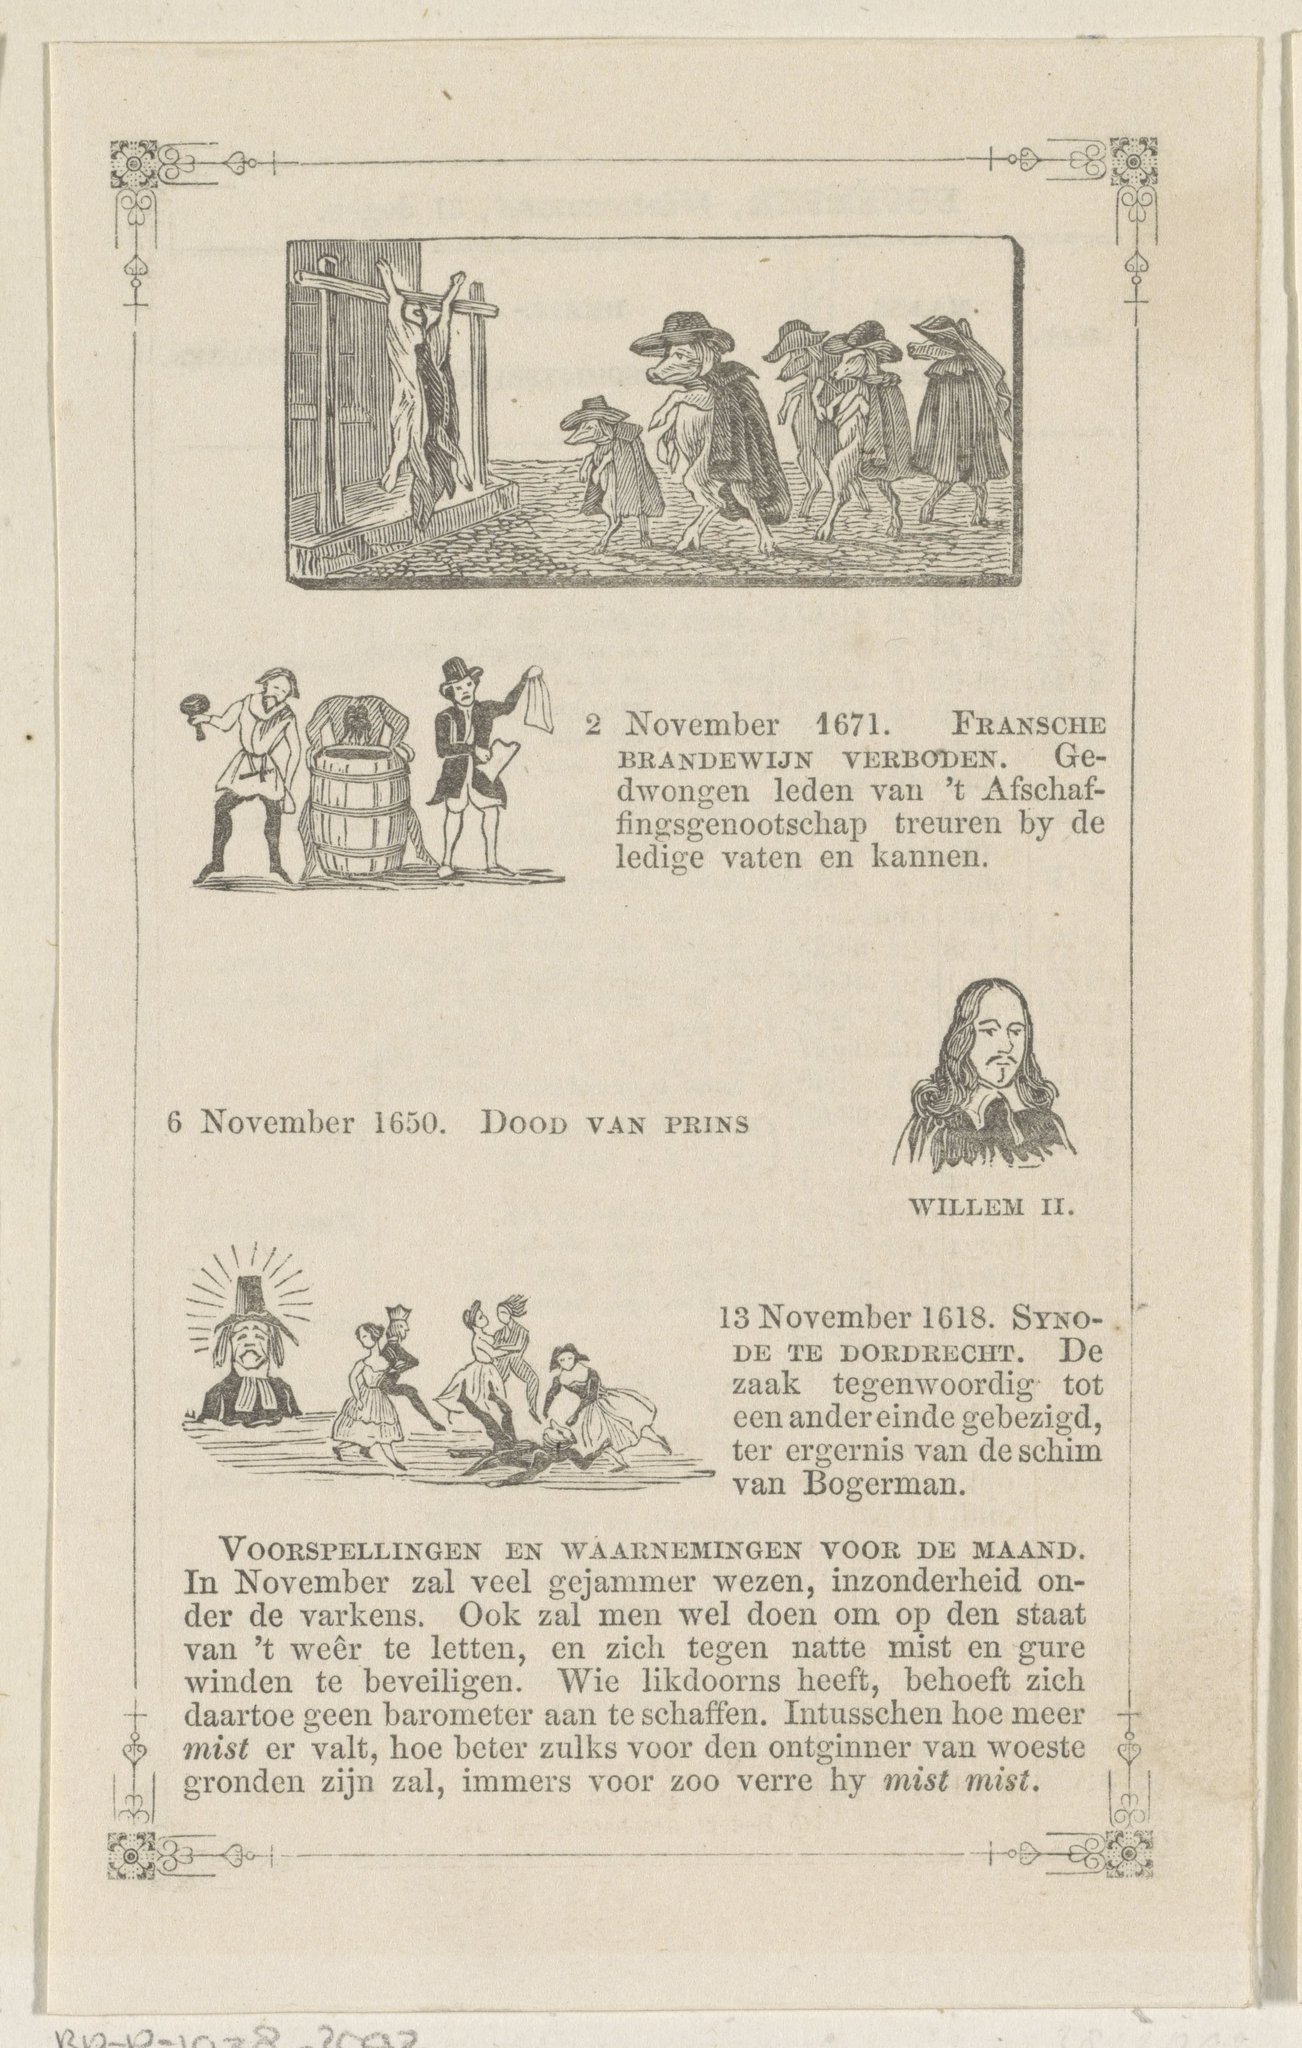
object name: print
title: November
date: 1849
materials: paper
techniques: letterpress printing, engraving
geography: netherlands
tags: overlijden van willem ii, prins van oranje, synode van dordrecht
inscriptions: collector's mark: Lugt 2228, collector's mark: Lugt 2760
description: Midden boven een voorstelling van aangeklede varkens treurend bij een uitgebeend varken. Daaronder een aantal voorstellingen van gebeurtenissen die plaatsvonden in de maand november, waaronder de dood van Willem II in 1650 en de synode van Dordrecht in 1618. Midden onder voorspellingen en waarnemeningen voor de maand november in 1849.